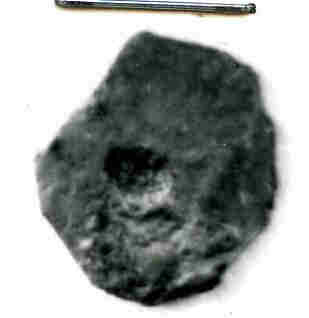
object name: coin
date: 601-1400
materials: copper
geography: iran